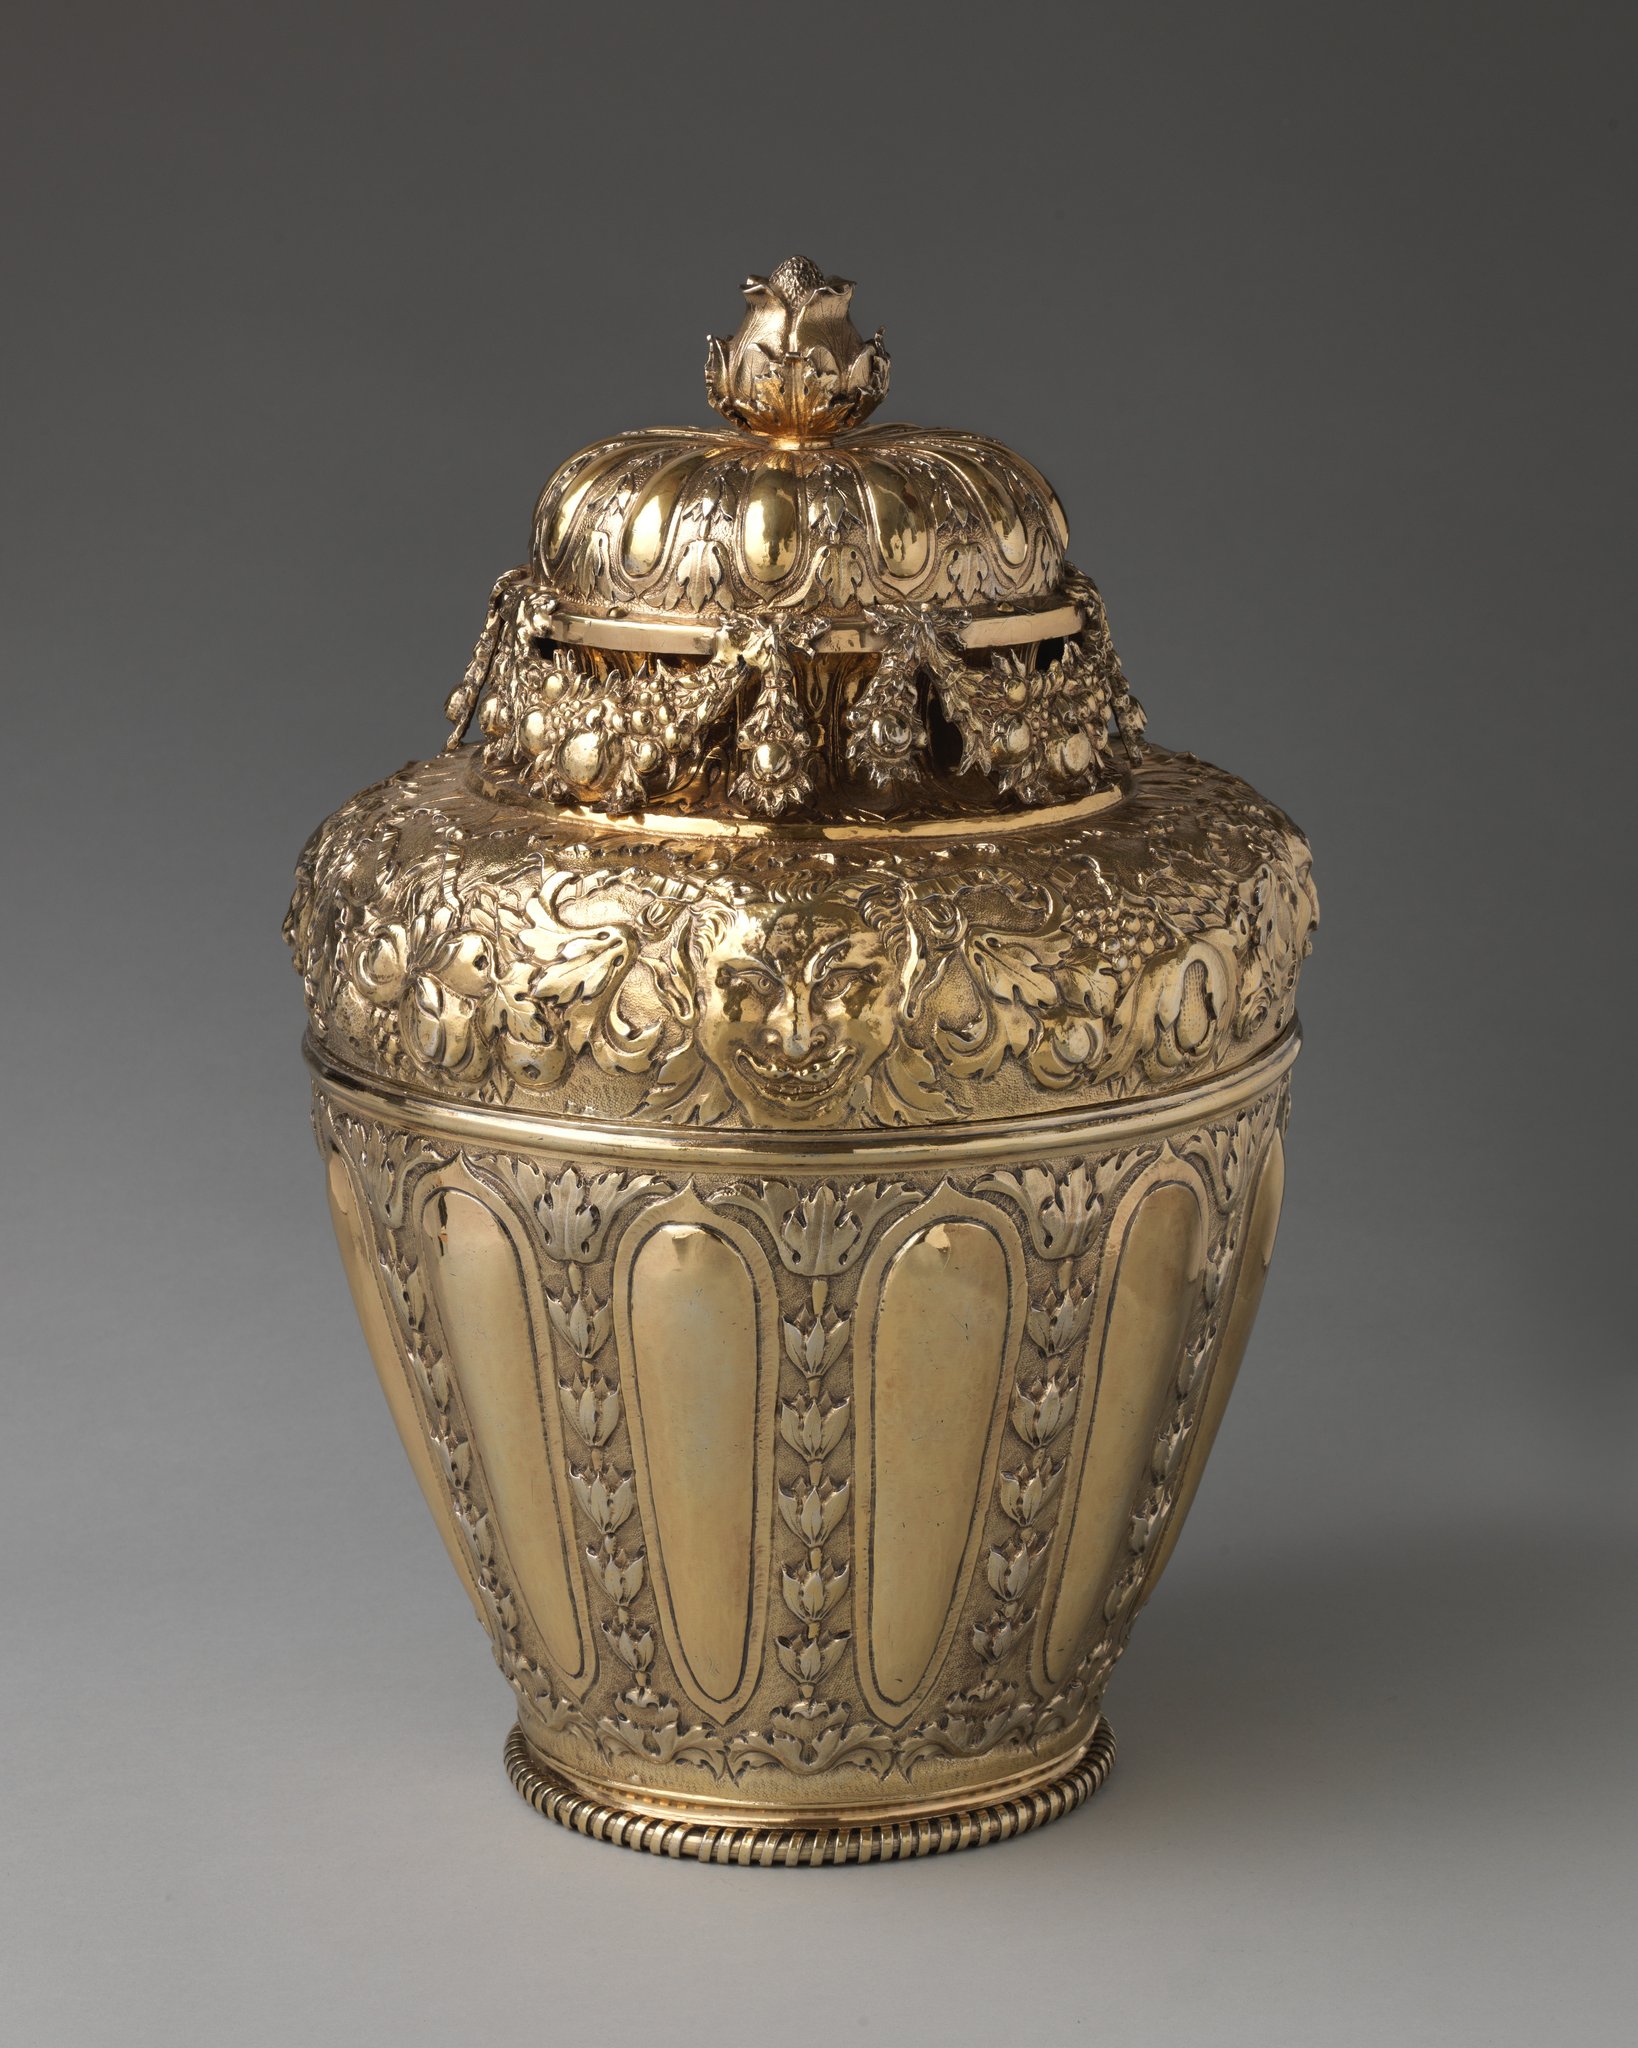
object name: vase with cover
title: Vase with cover (one of a pair)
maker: i h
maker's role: maker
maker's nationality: british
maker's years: 1650-1699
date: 1675-1676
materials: silver gilt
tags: masks